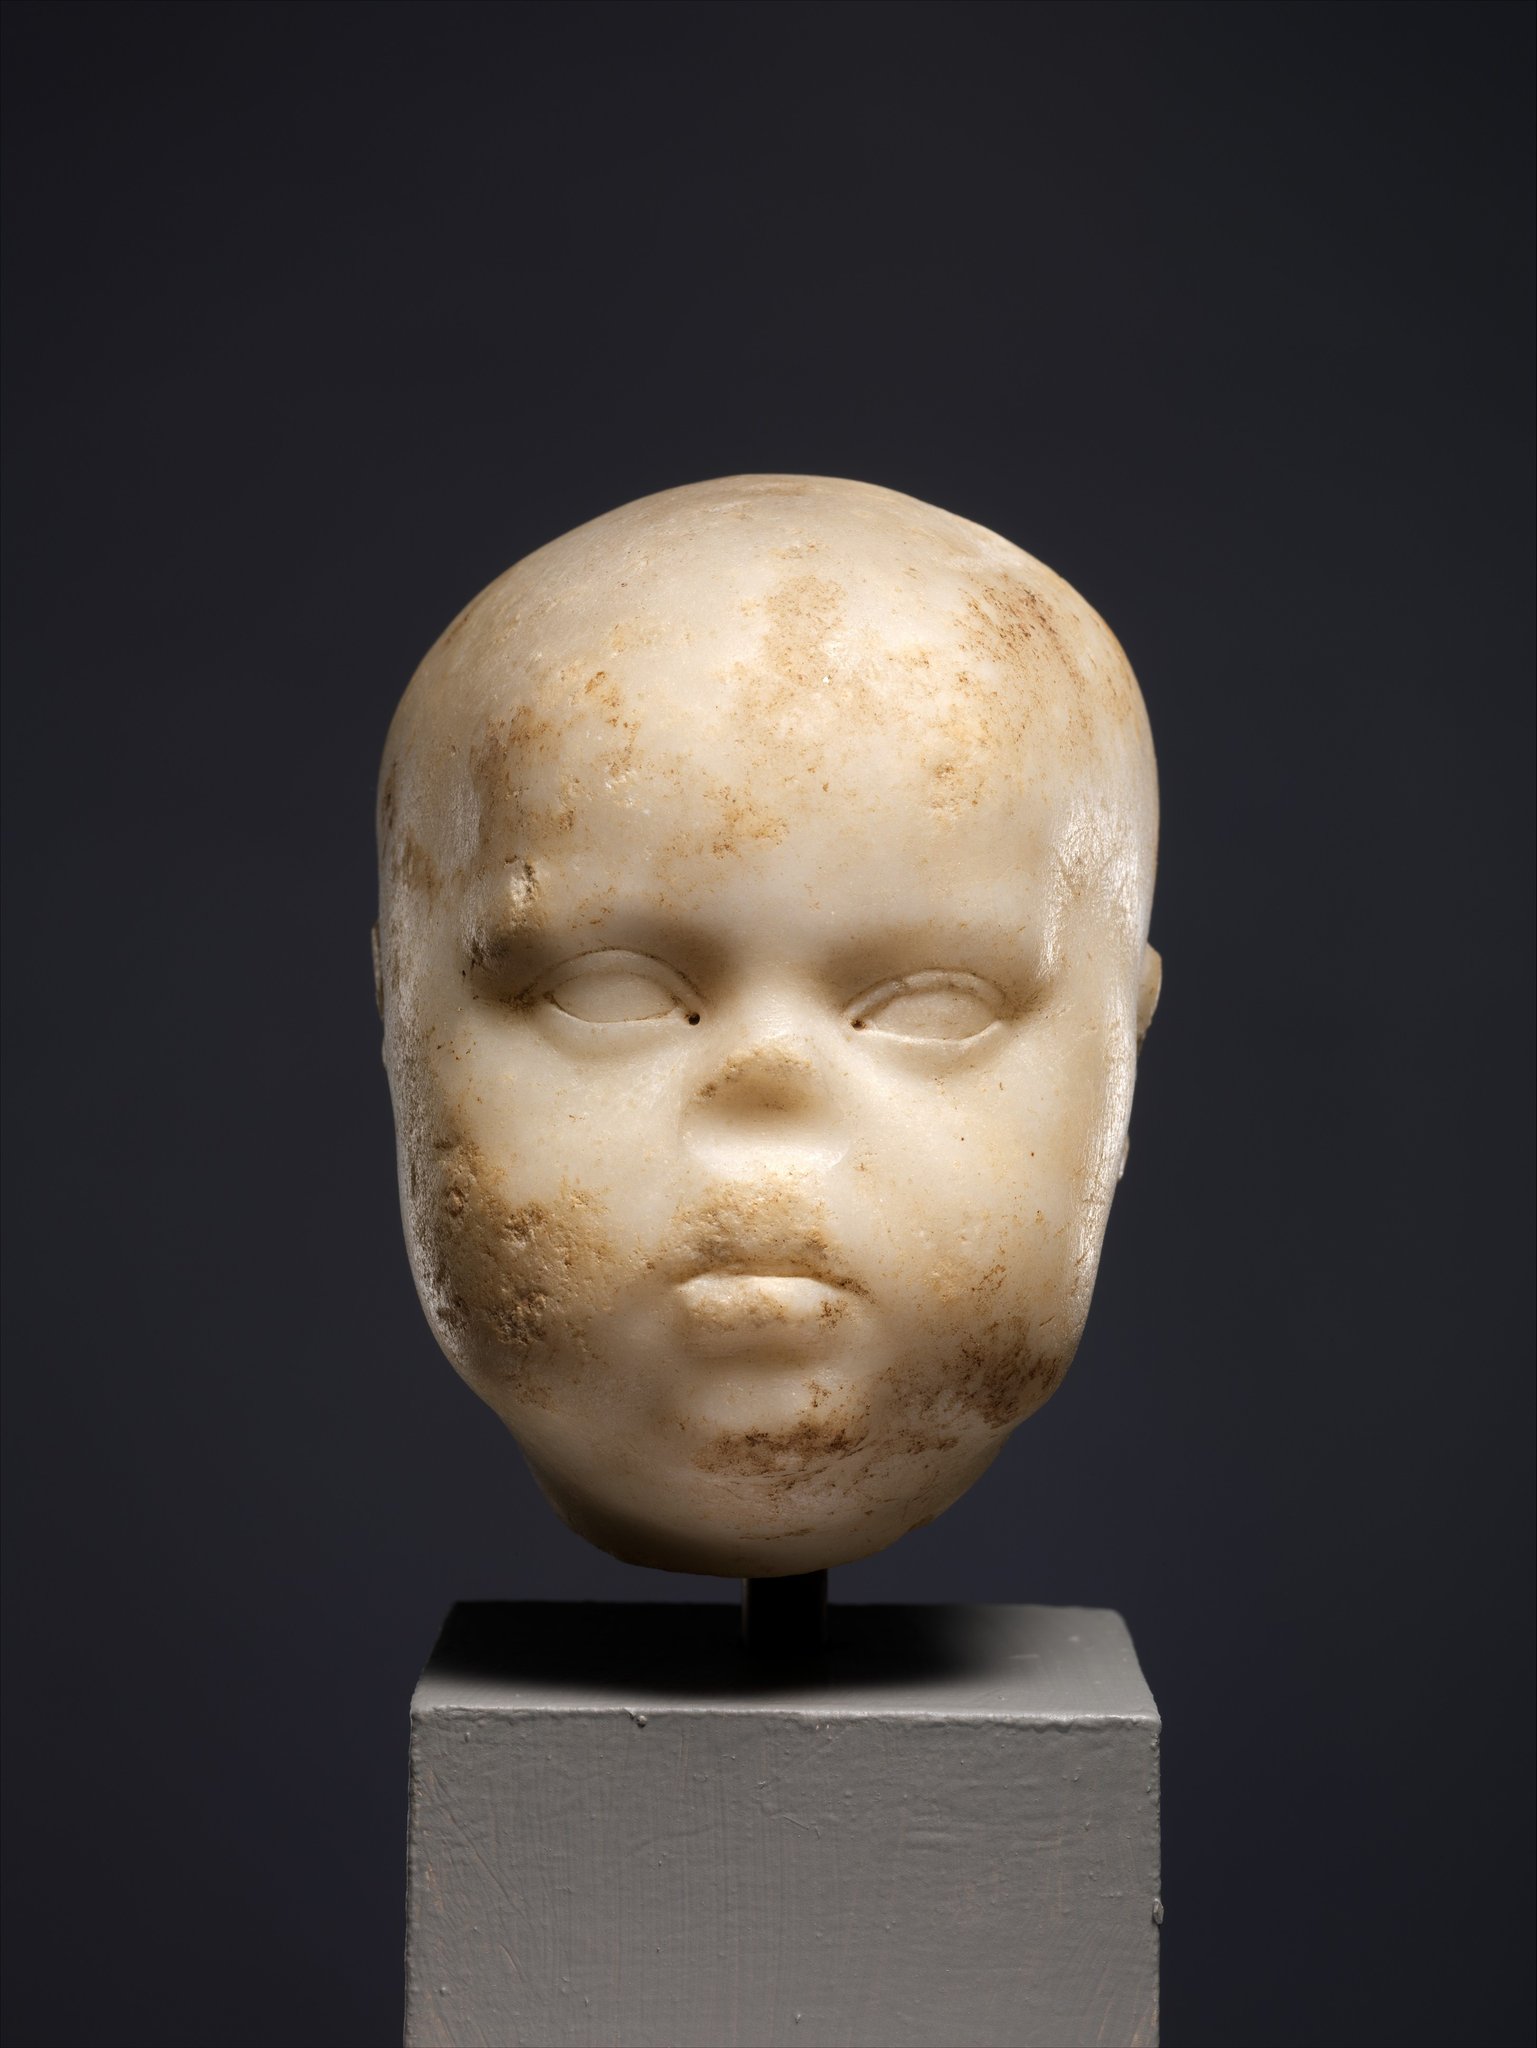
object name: head of a baby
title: Marble head of a baby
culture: roman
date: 100 BCE-100 CE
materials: marble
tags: heads,infants